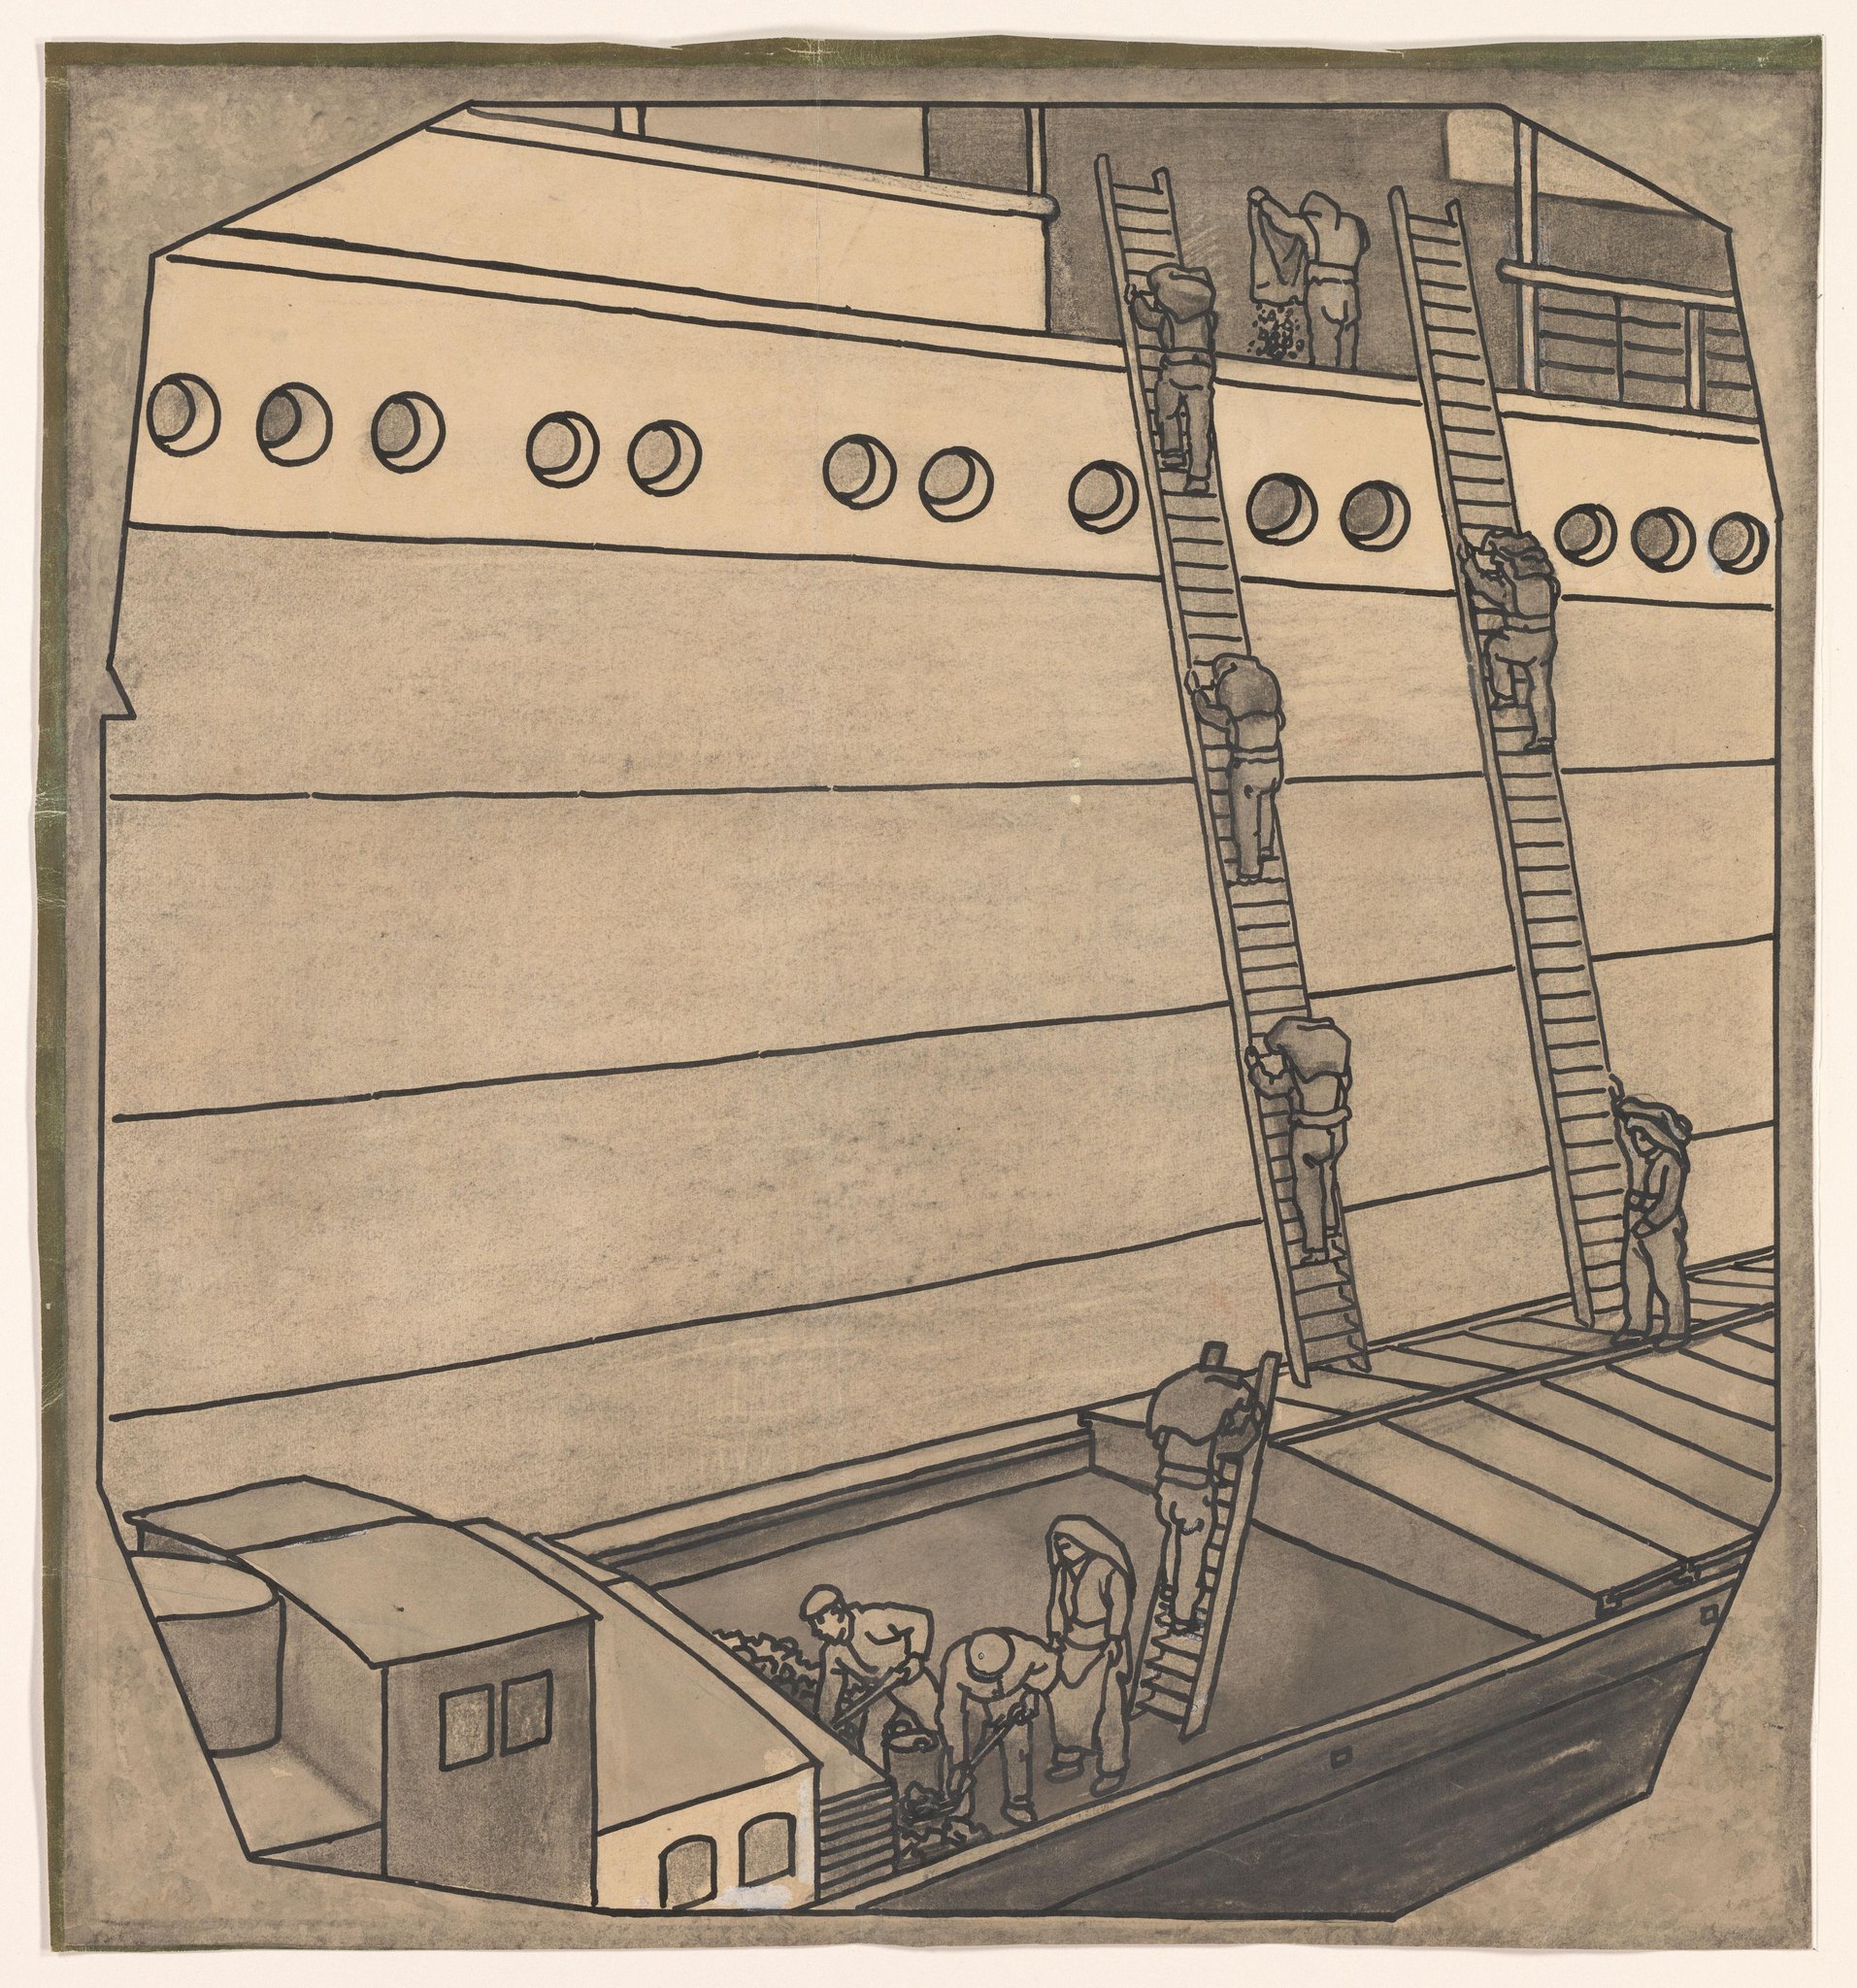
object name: drawing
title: Ontwerptekening voor rechter zijkant van tegeltableau ter ere van het 25-jarig bestaan van de Steenkolen-Handelsvereeniging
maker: carel adolph lion cachet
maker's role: draughtsman, print maker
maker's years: 1864-1945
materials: chalk, paint, paper, pencil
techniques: brush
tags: steamship, motorship (+ taking in fuel; feeding the animals), anthracite, hard coal, names of organizations, companies, trade unions, etc., porter, bearer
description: Het tegeltableau is waarschijnlijk bewaard in het hoofdkantoor van SHV Holdings aan de Rijnkade te Utrecht.